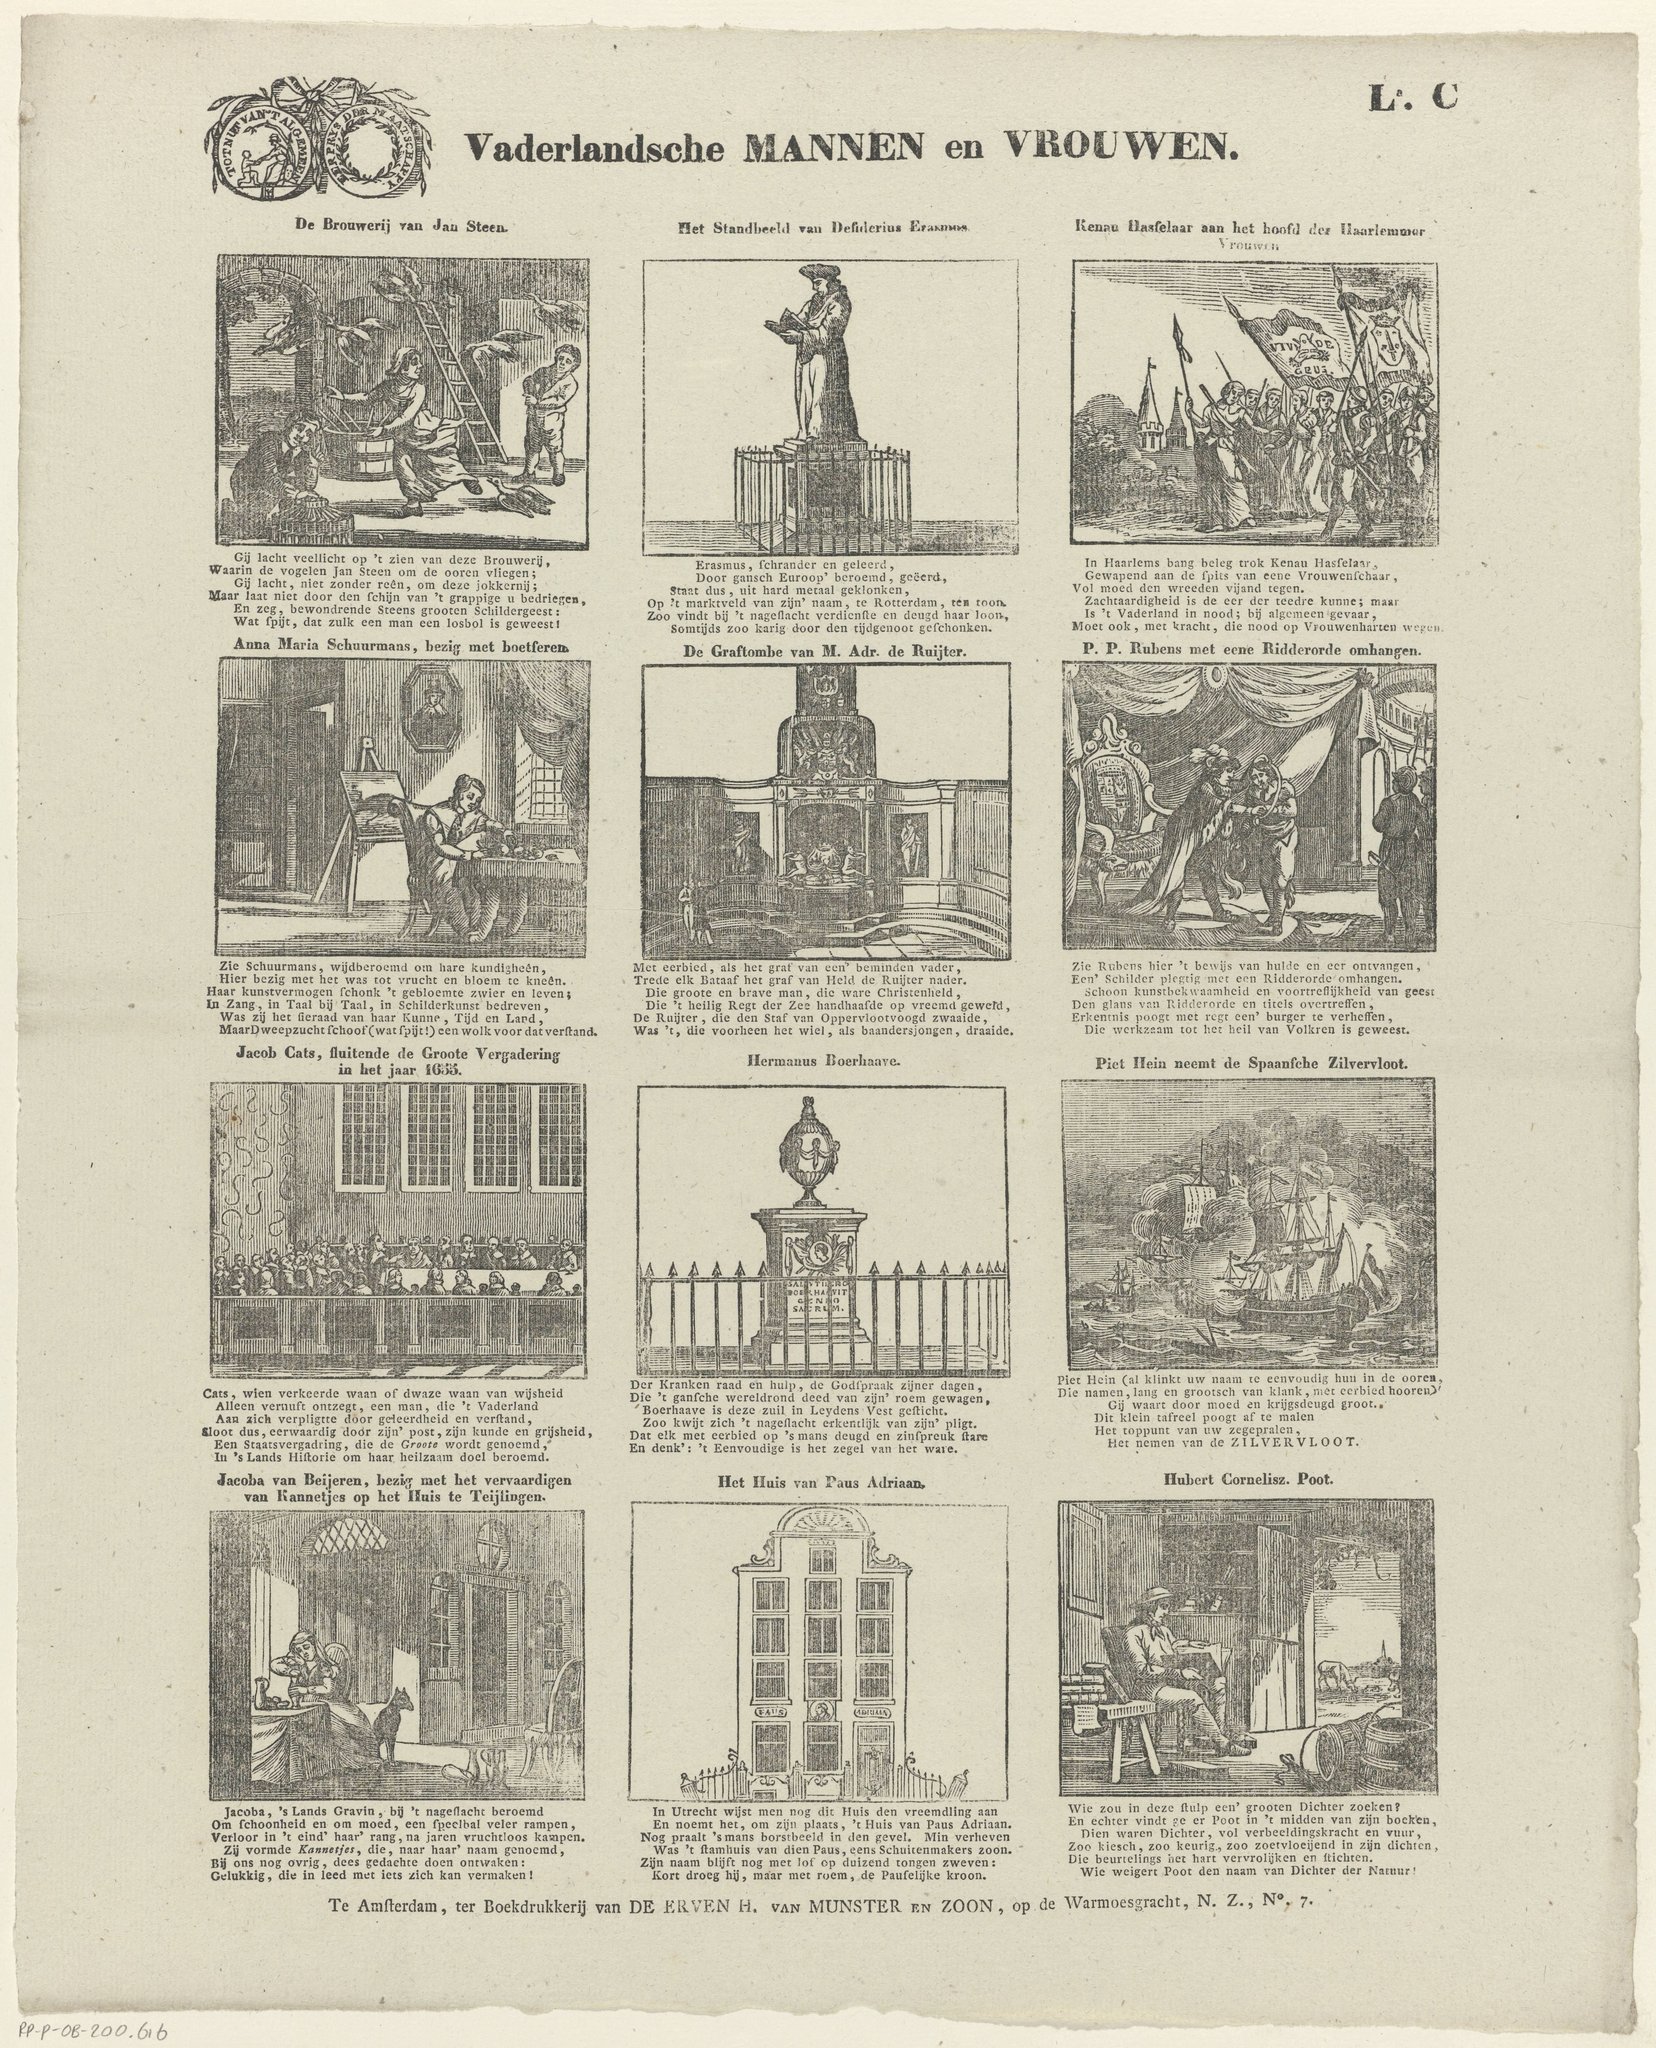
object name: popular print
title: Vaderlandsche mannen en vrouwen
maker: alexander cranendoncq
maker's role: draughtsman, print maker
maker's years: 1799-1869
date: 1829-1856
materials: paper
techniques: letterpress printing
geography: amsterdam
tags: cologne, anna maria van schurman, jan havicksz. steen, jacoba of bavaria (countess of hainaut), rotterdam, desiderius erasmus, flushing, michiel adriaenszoon de ruyter, delfshaven, delft, hubert kornelisz. poot, antwerp, painter, print maker, draughtsman, peter paul rubens, priest, utrecht, leiden, hermanus boerhaave, housing, monument, statue, classical mythology and ancient history, netherlands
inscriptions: collector's mark: Lugt 2760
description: Blad met 12 voorstellingen van bezigheden, huizen of monumenten van beroemde Nederlandse mannen en vrouwen, waaronder Jan Steen, Erasmus en Jacob Cats. Onder elke afbeelding een zesregelig vers en boven elke afbeelding een titel. Linksboven het zegel van de Maatschappij tot Nut van 't Algemeen. Gemerkt rechtsboven: L. C.